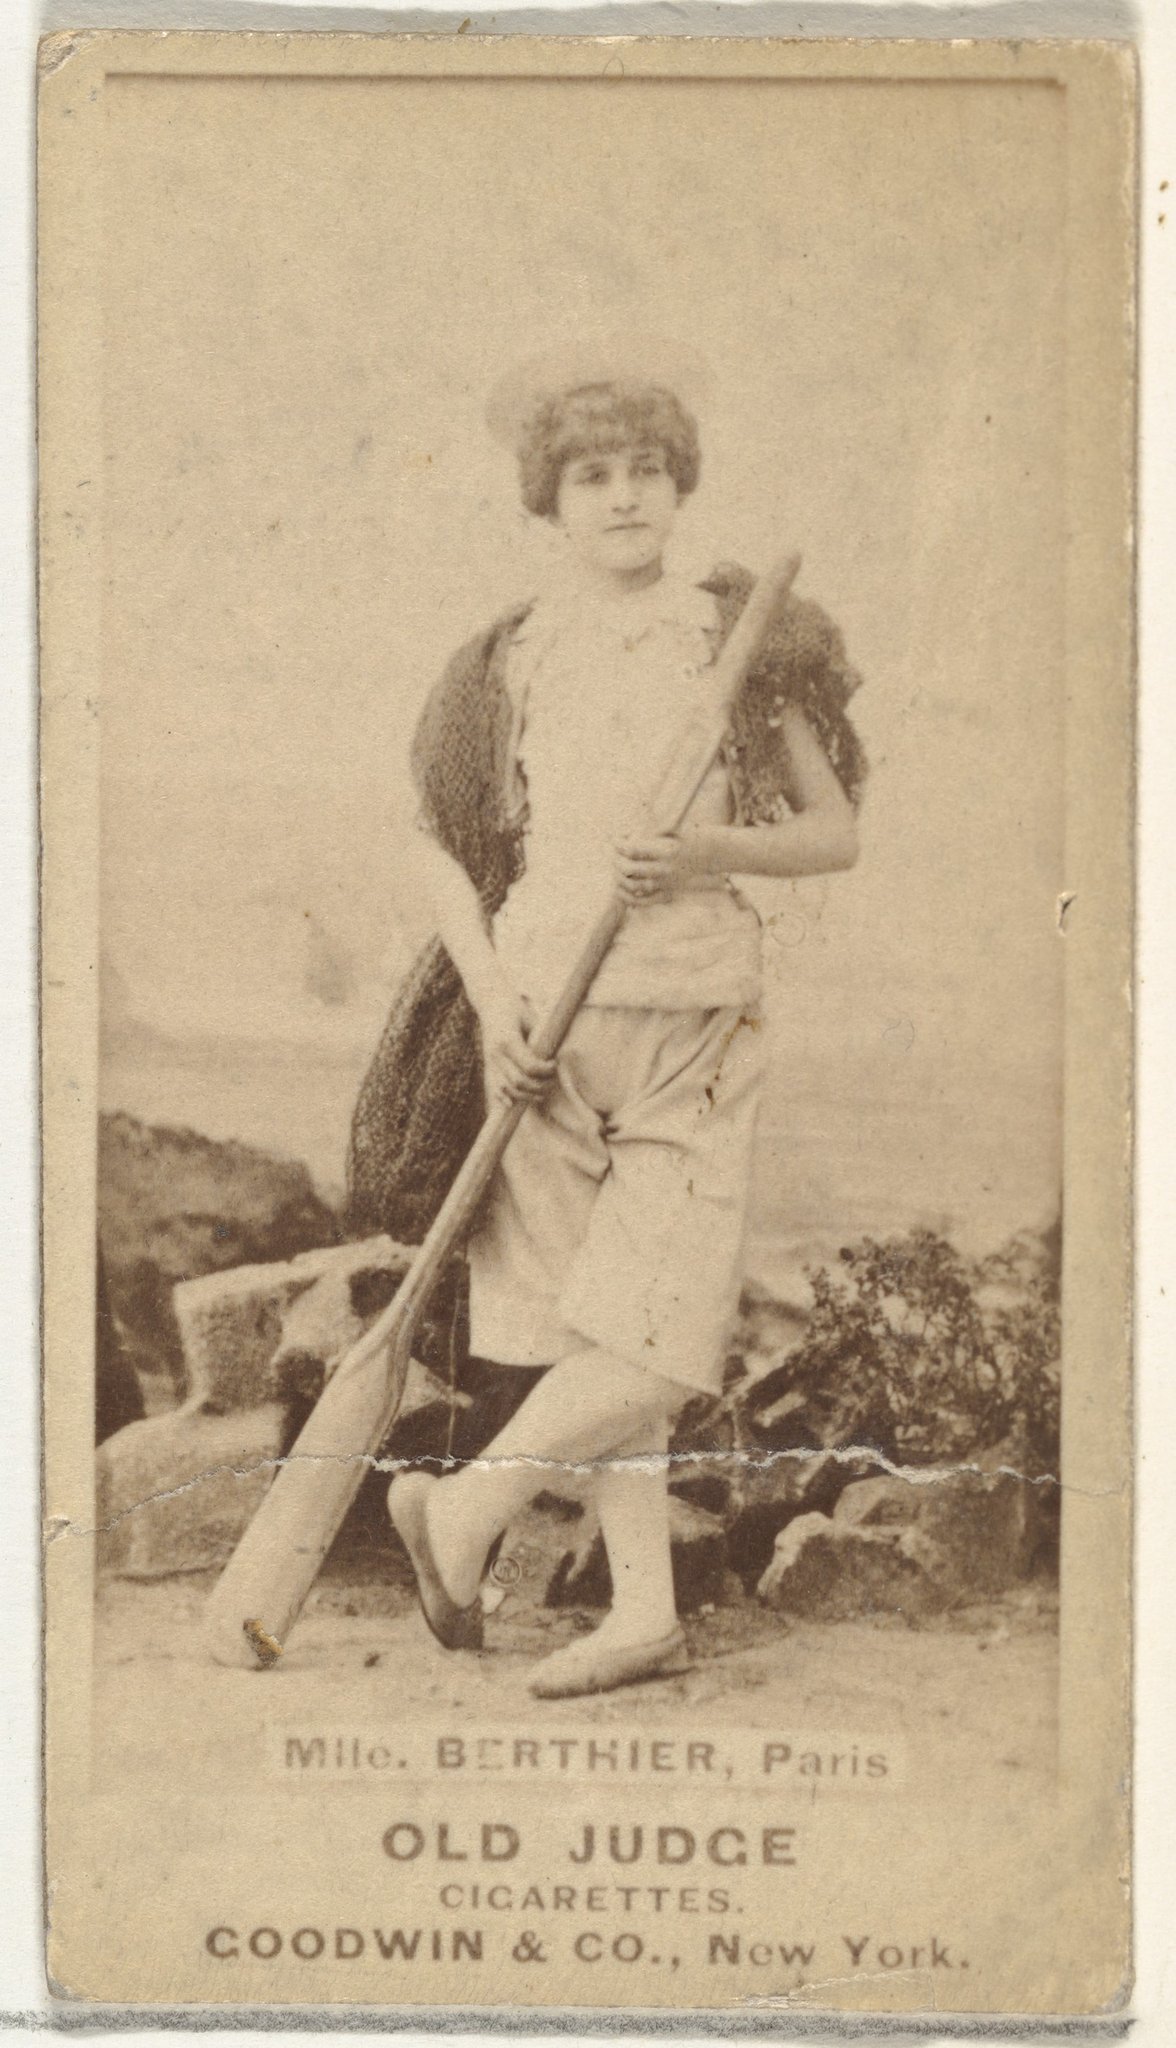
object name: photograph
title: Mlle. Berthier, Paris, from the Actors and Actresses series (N171) for Old Judge Cigarettes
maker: goodwin & company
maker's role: publisher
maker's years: 1850-1950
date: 1886-1890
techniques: albumen silver print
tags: girls,portraits